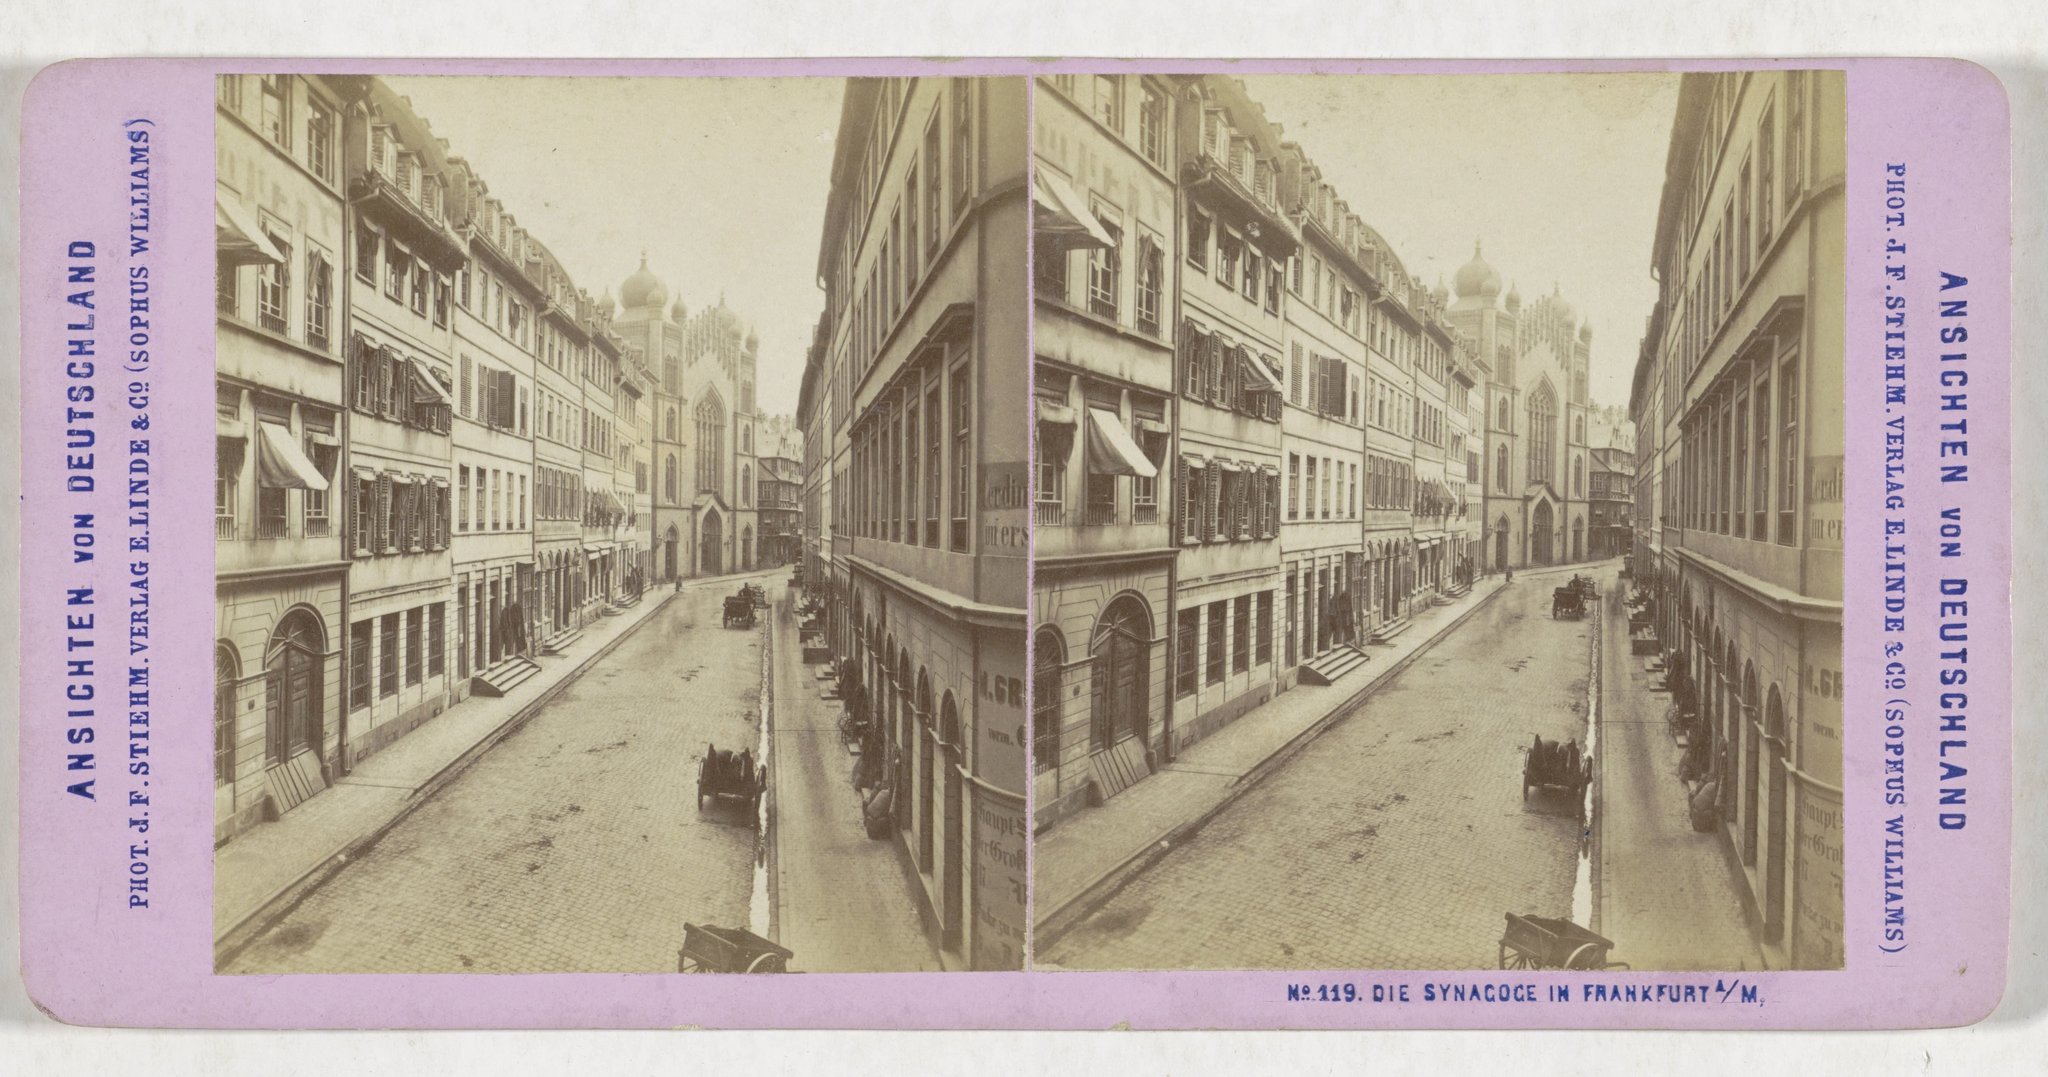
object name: stereograph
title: Synagoge in de Börnestrasse, Frankfurt am Main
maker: johann friedrich stiehm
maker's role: fotograaf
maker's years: 1826-1902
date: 1869-1872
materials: cardboard, paper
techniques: albumen print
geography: berlin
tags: the synagogue (as building and place of worship ~ jewish religion), street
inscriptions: number: ‘No 119.’